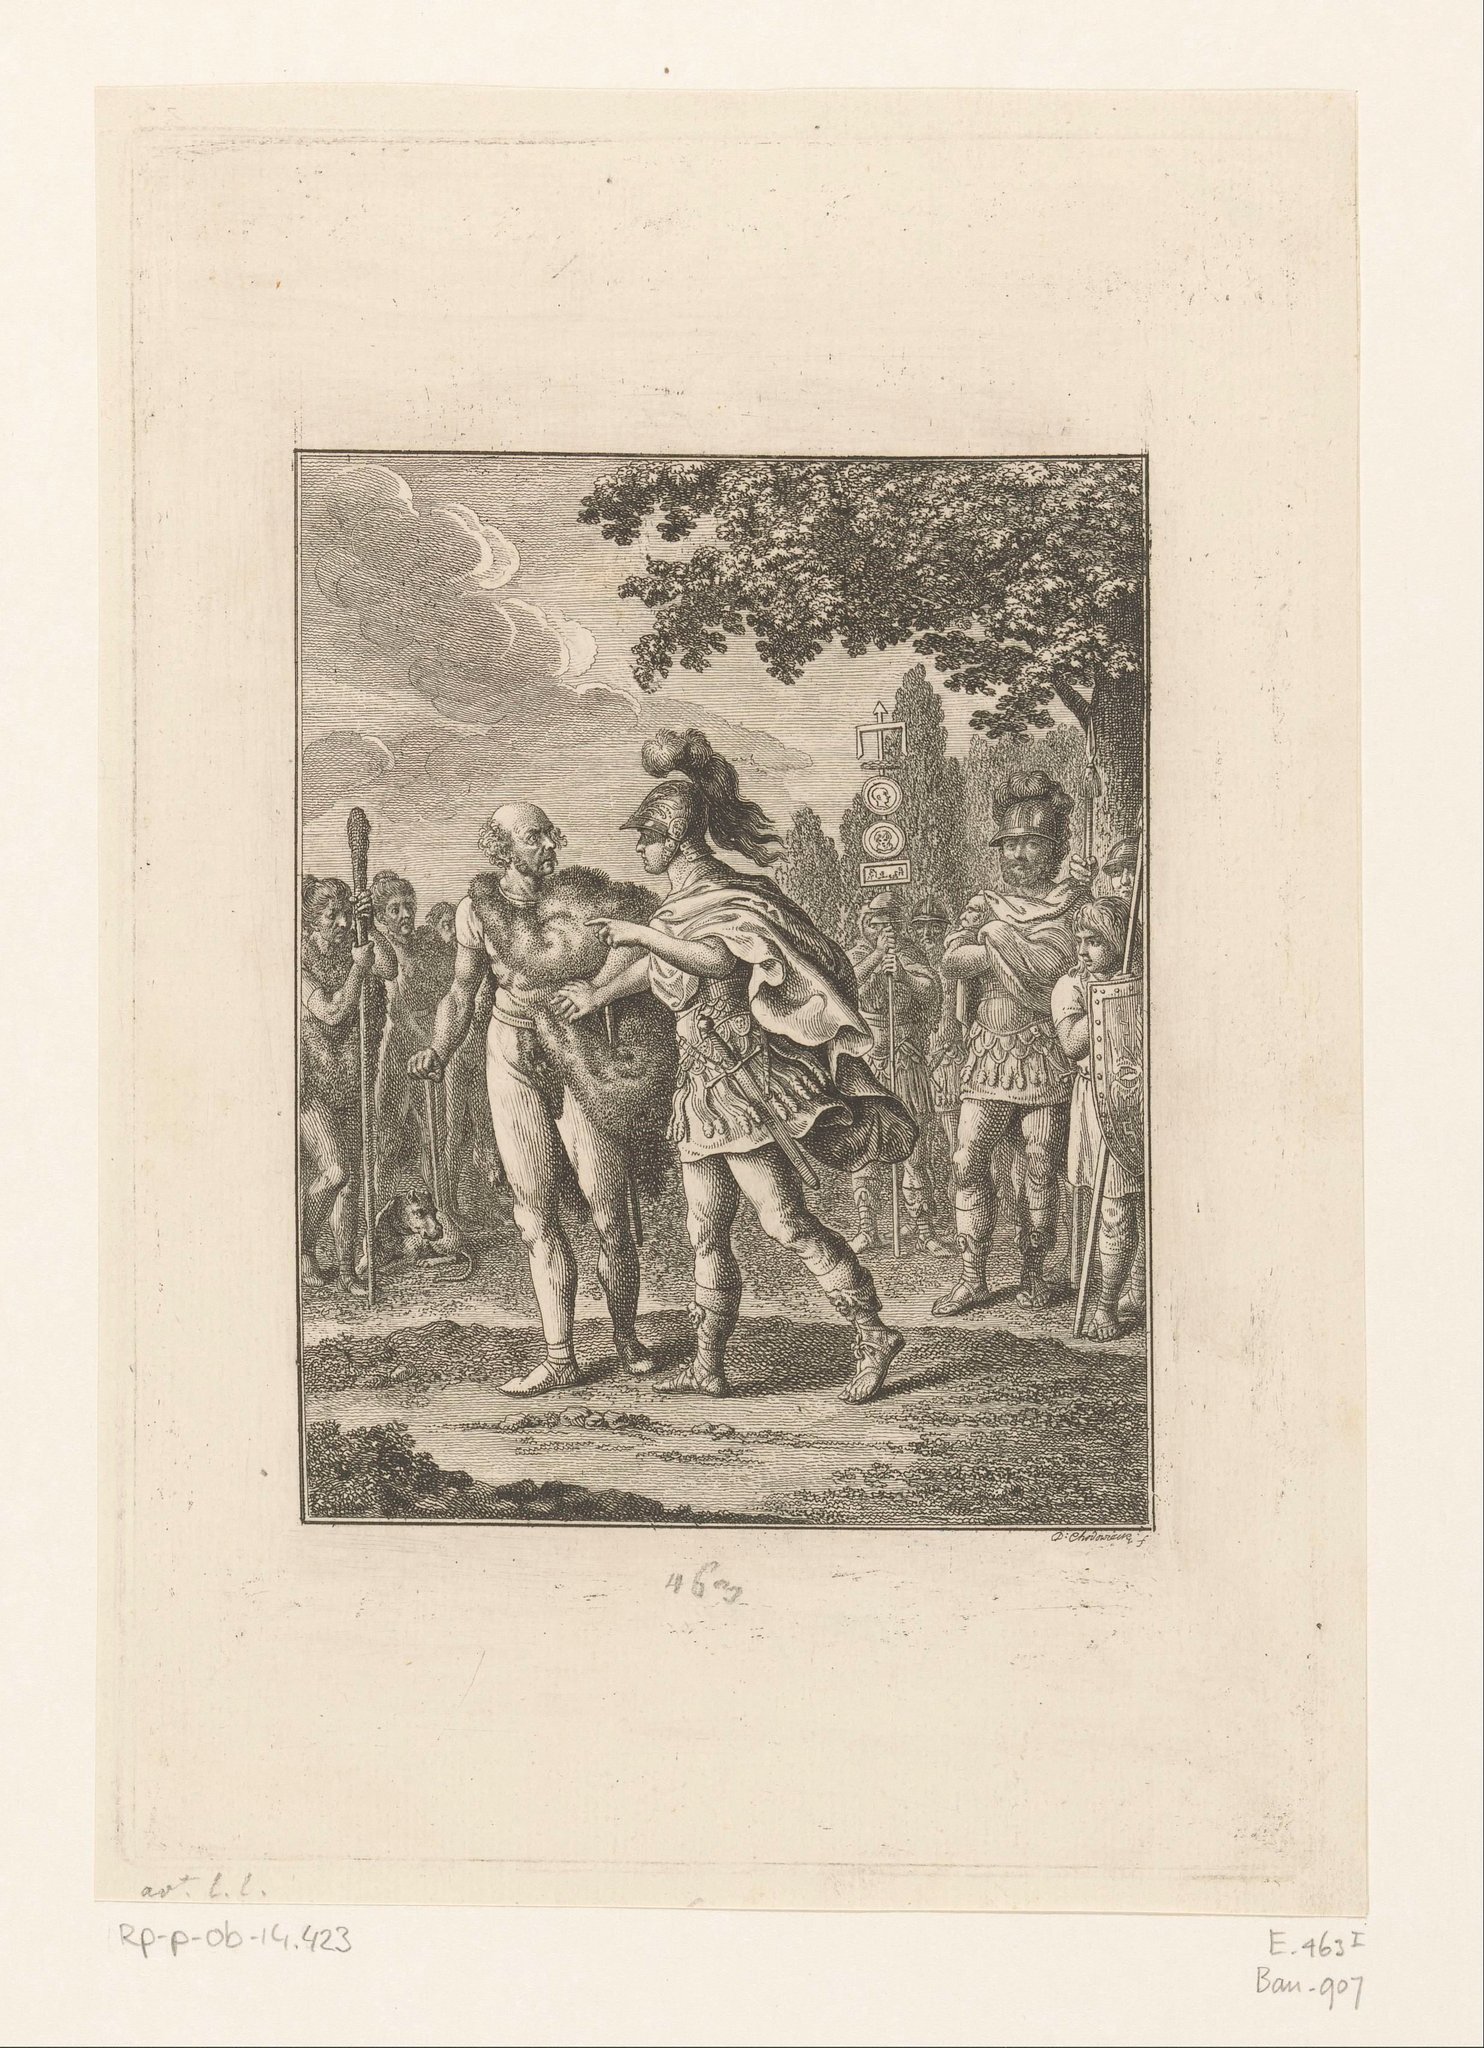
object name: print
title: Bojokal en Avitus in gesprek over de verdeling van het land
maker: daniel nikolaus chodowiecki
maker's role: draughtsman, print maker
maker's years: 1726-1801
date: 1785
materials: paper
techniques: etching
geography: berlin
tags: armour, after the battle, conversation, dialogue; conversation piece, (military) flags and standards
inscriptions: collector's mark: Lugt 2228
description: Prent gebruikt voor: Klein, Anton. Leben und Bildnisse der Grossen Deutschen, von verschiedenen Verfassern und Künstlern (...). 3 dln. Mannheim: s.n., 1785, dl. 1.